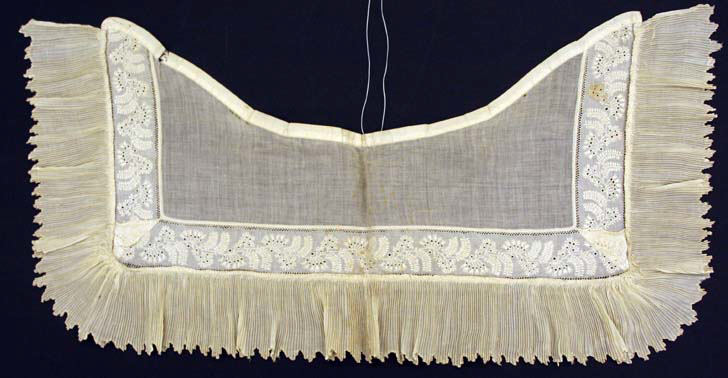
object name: collar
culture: american or european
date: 1700-1945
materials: cotton